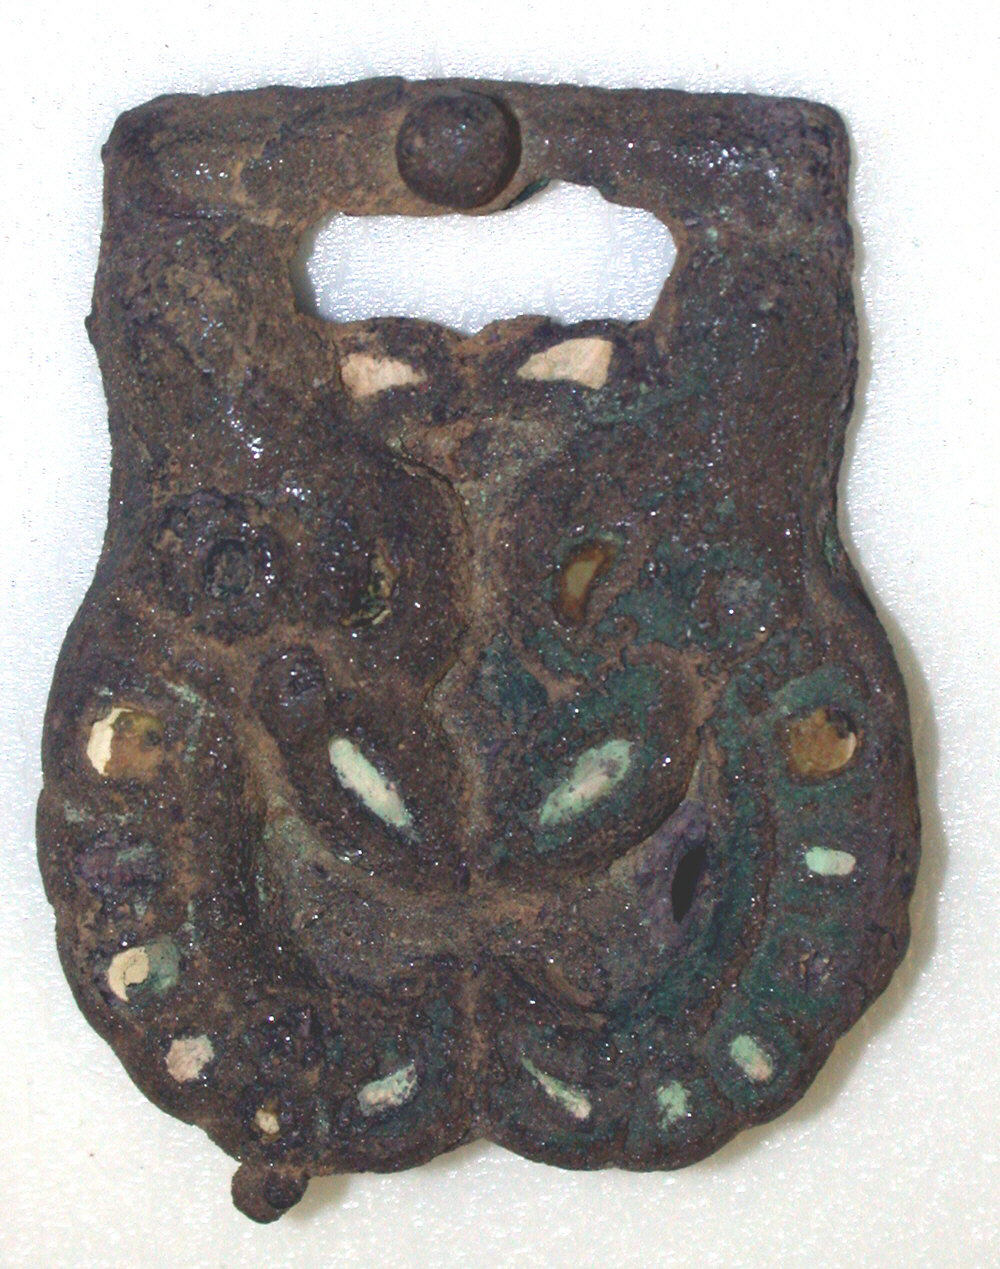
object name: buckle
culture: xiongnu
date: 300-101 BCE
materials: silver, stone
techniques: inlay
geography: eurasian steppes